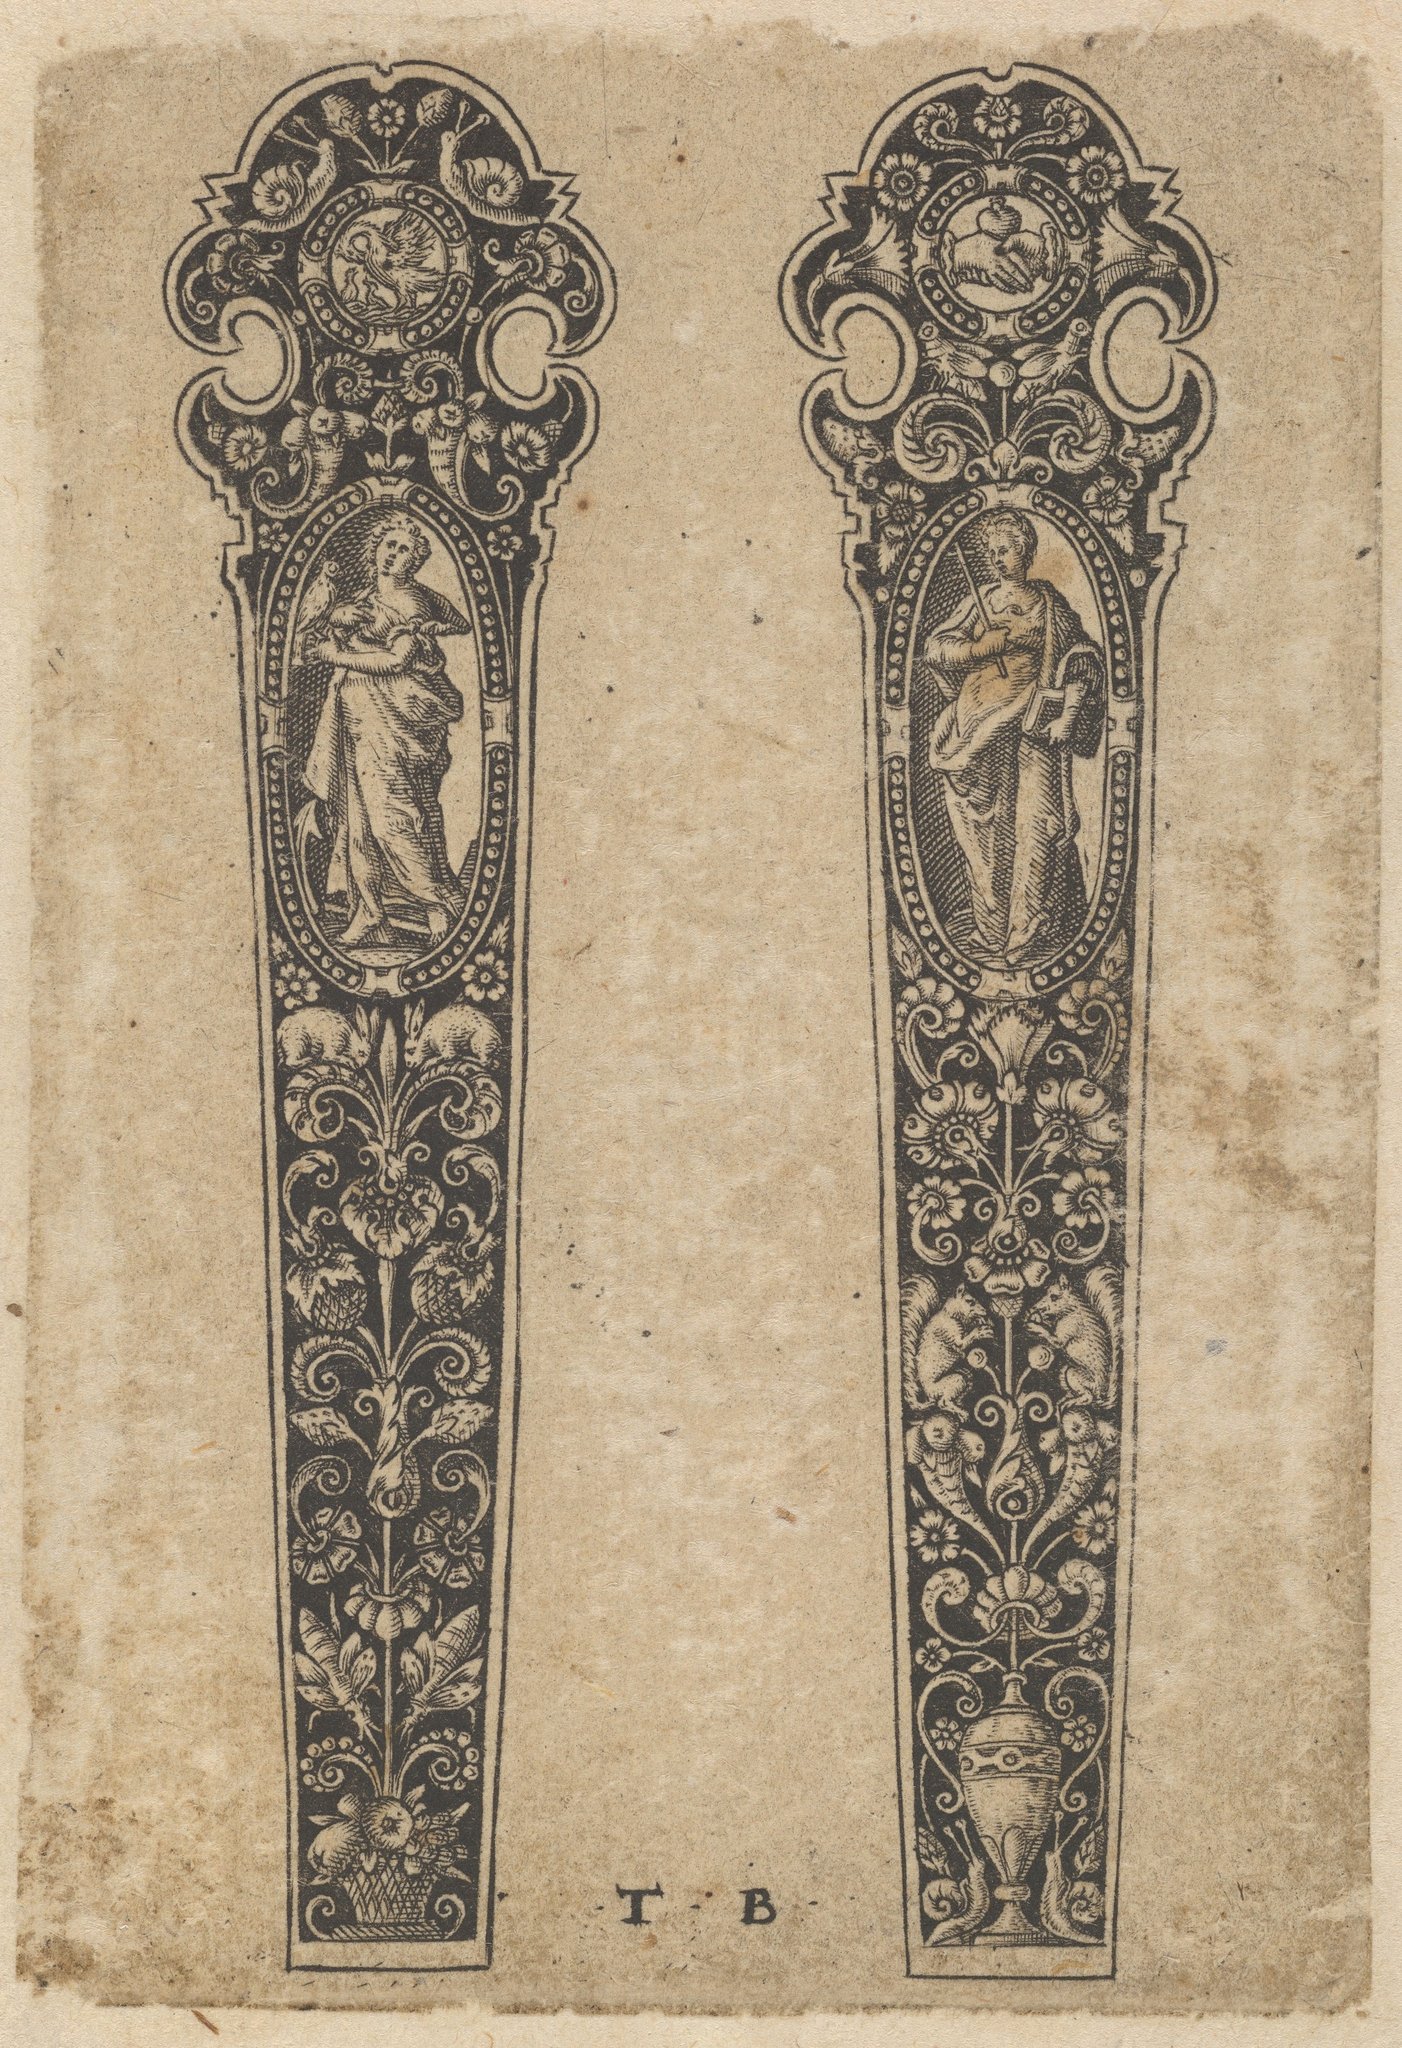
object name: print ornament architecture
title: Design for Knife Handles with Personifications of Peace and Faith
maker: johann theodor de bry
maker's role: artist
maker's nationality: netherlandish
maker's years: 1561-1623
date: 1580-1600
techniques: embroidery, engraving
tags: birds,women,rabbits,squirrels,cross